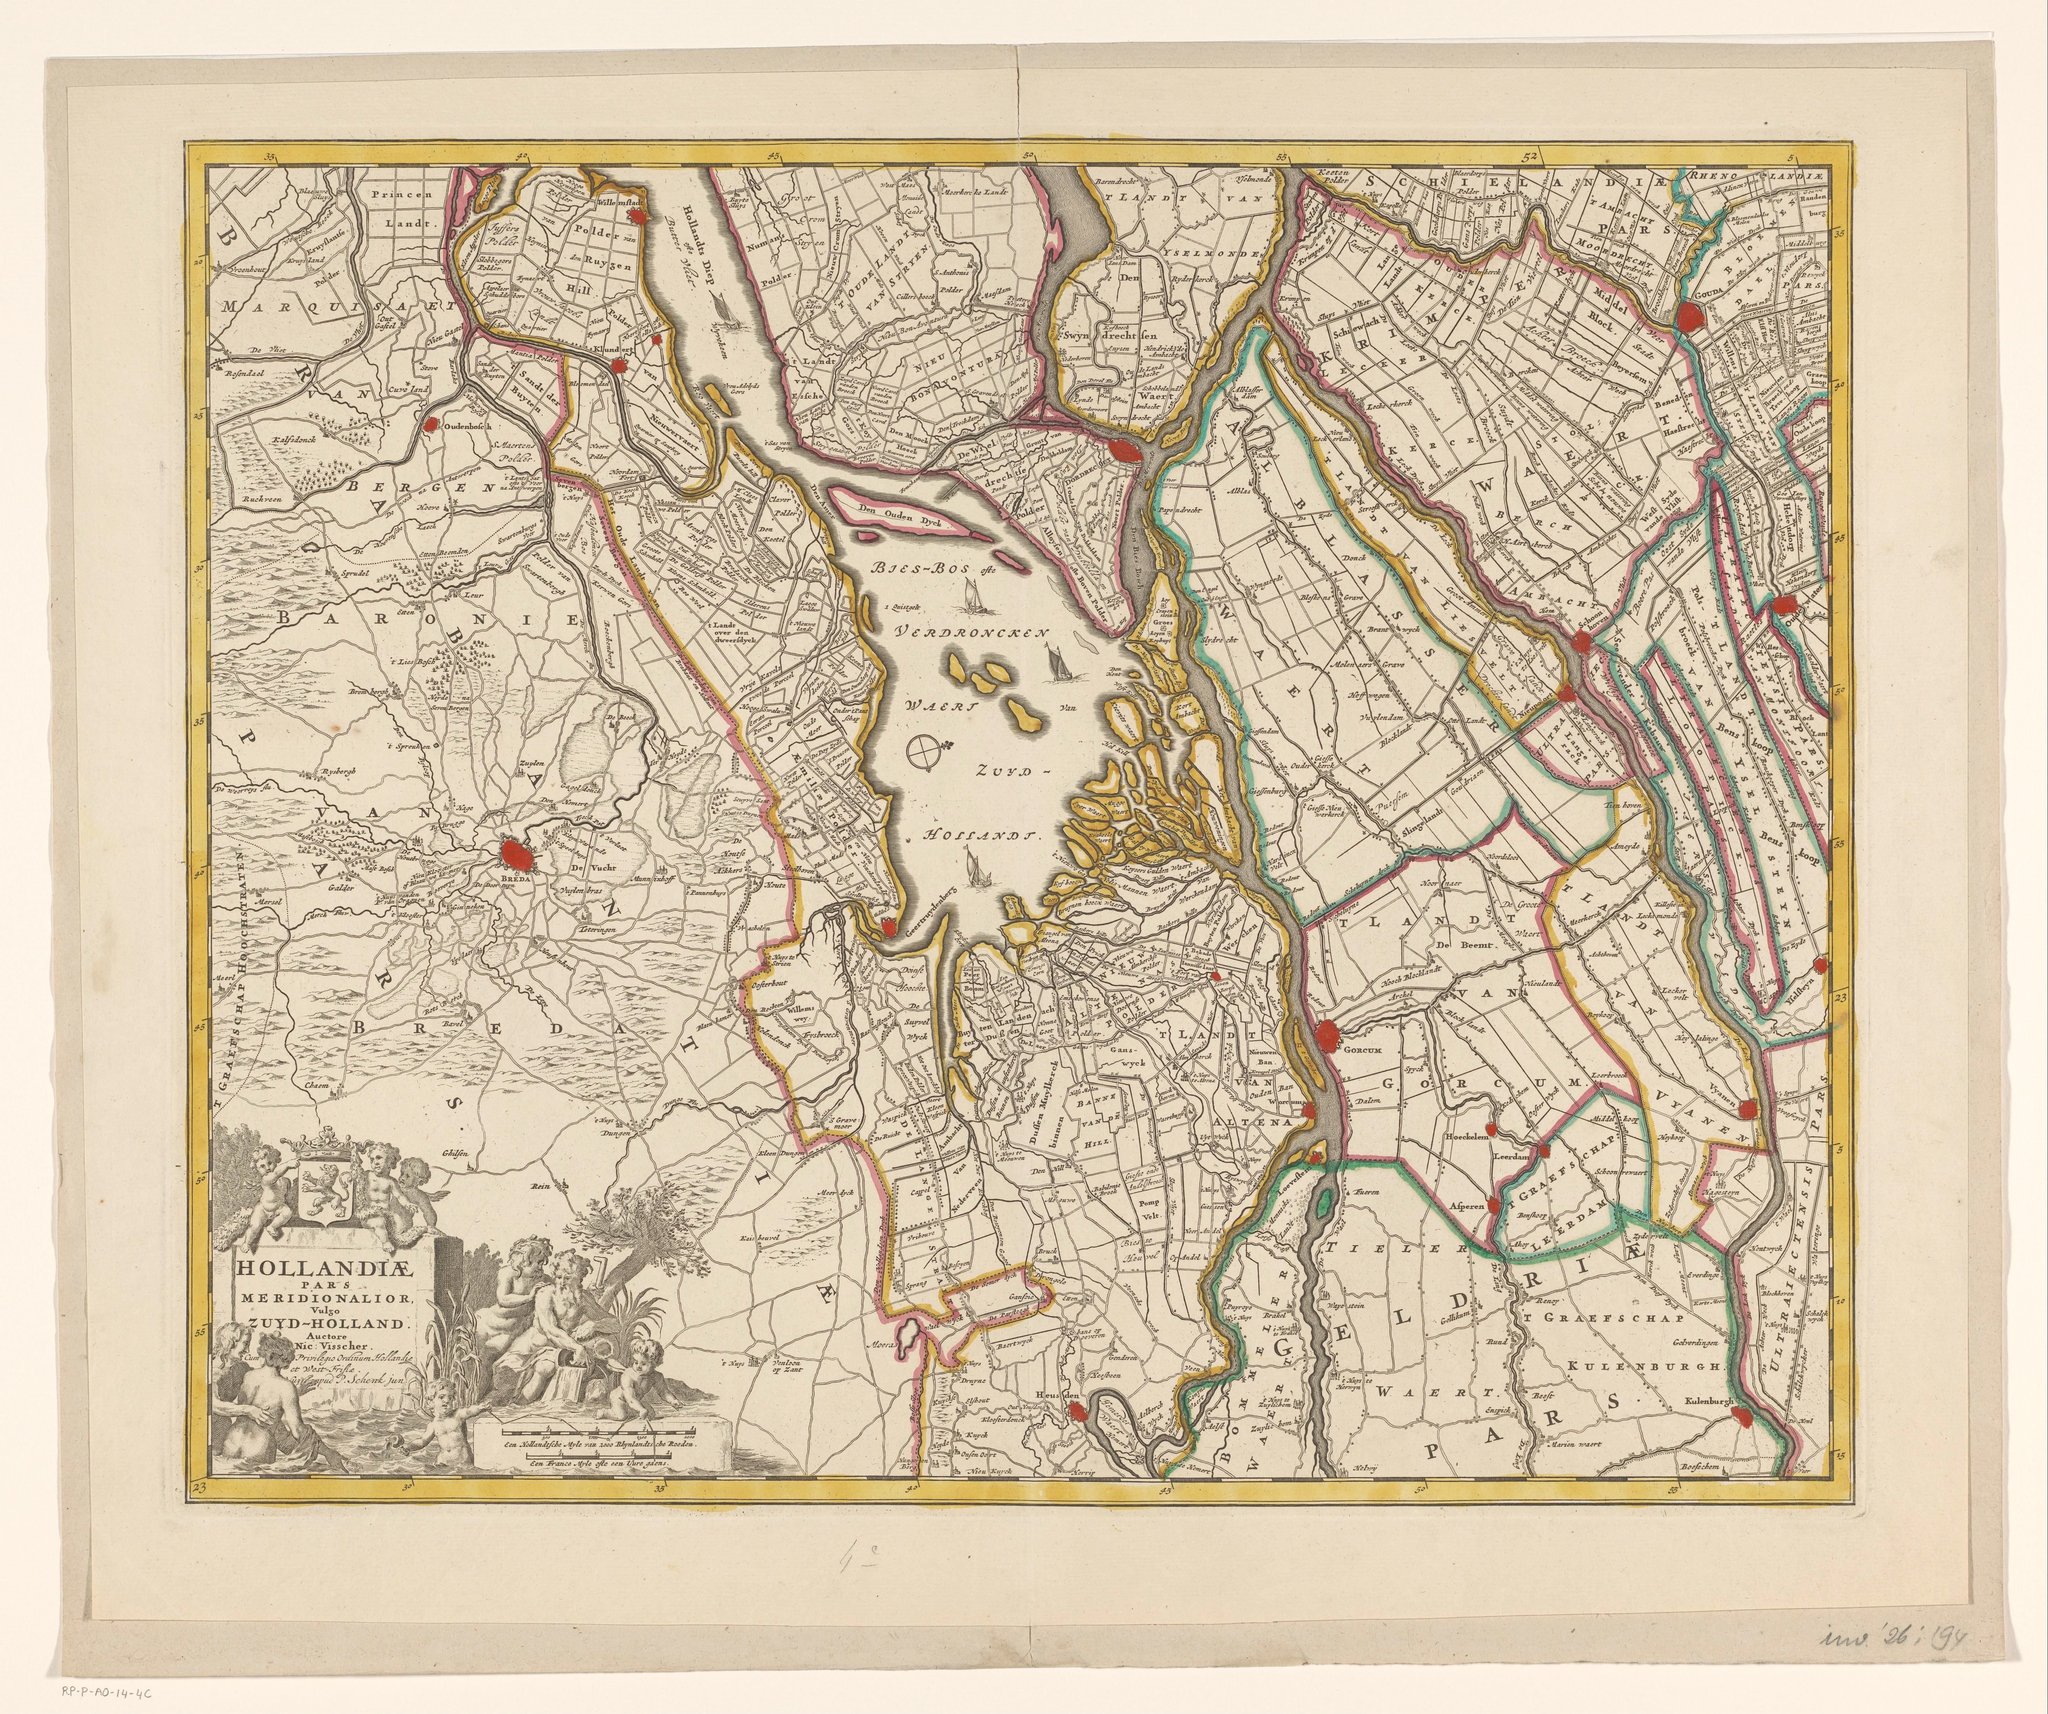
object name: print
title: Hollandiae pars meridionalior vulgo Zuyd-Holland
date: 1688-1720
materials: paper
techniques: engraving, etching, hand coloring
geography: amsterdam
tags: coat of arms (as symbol of the state, etc.) (+ city; municipal), maps of separate countries or regions, river-gods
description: Kaart van een deel van Zuid-Holland rond de Biesbos. Linksonder de titelcartouche met daarboven het wapen van Holland. Daaromheen putti en een aantal figuren, waaronder een riviergod. Rechts van de titelcartouche in het water een cartouche met twee schaalstokken: Een Hollandtsche myle van 2000 Rhynlandtsche roeden; Een France myle ofte een uure gaens. Gradenverdeling langs de randen. Oriëntatie: noorden rechts.